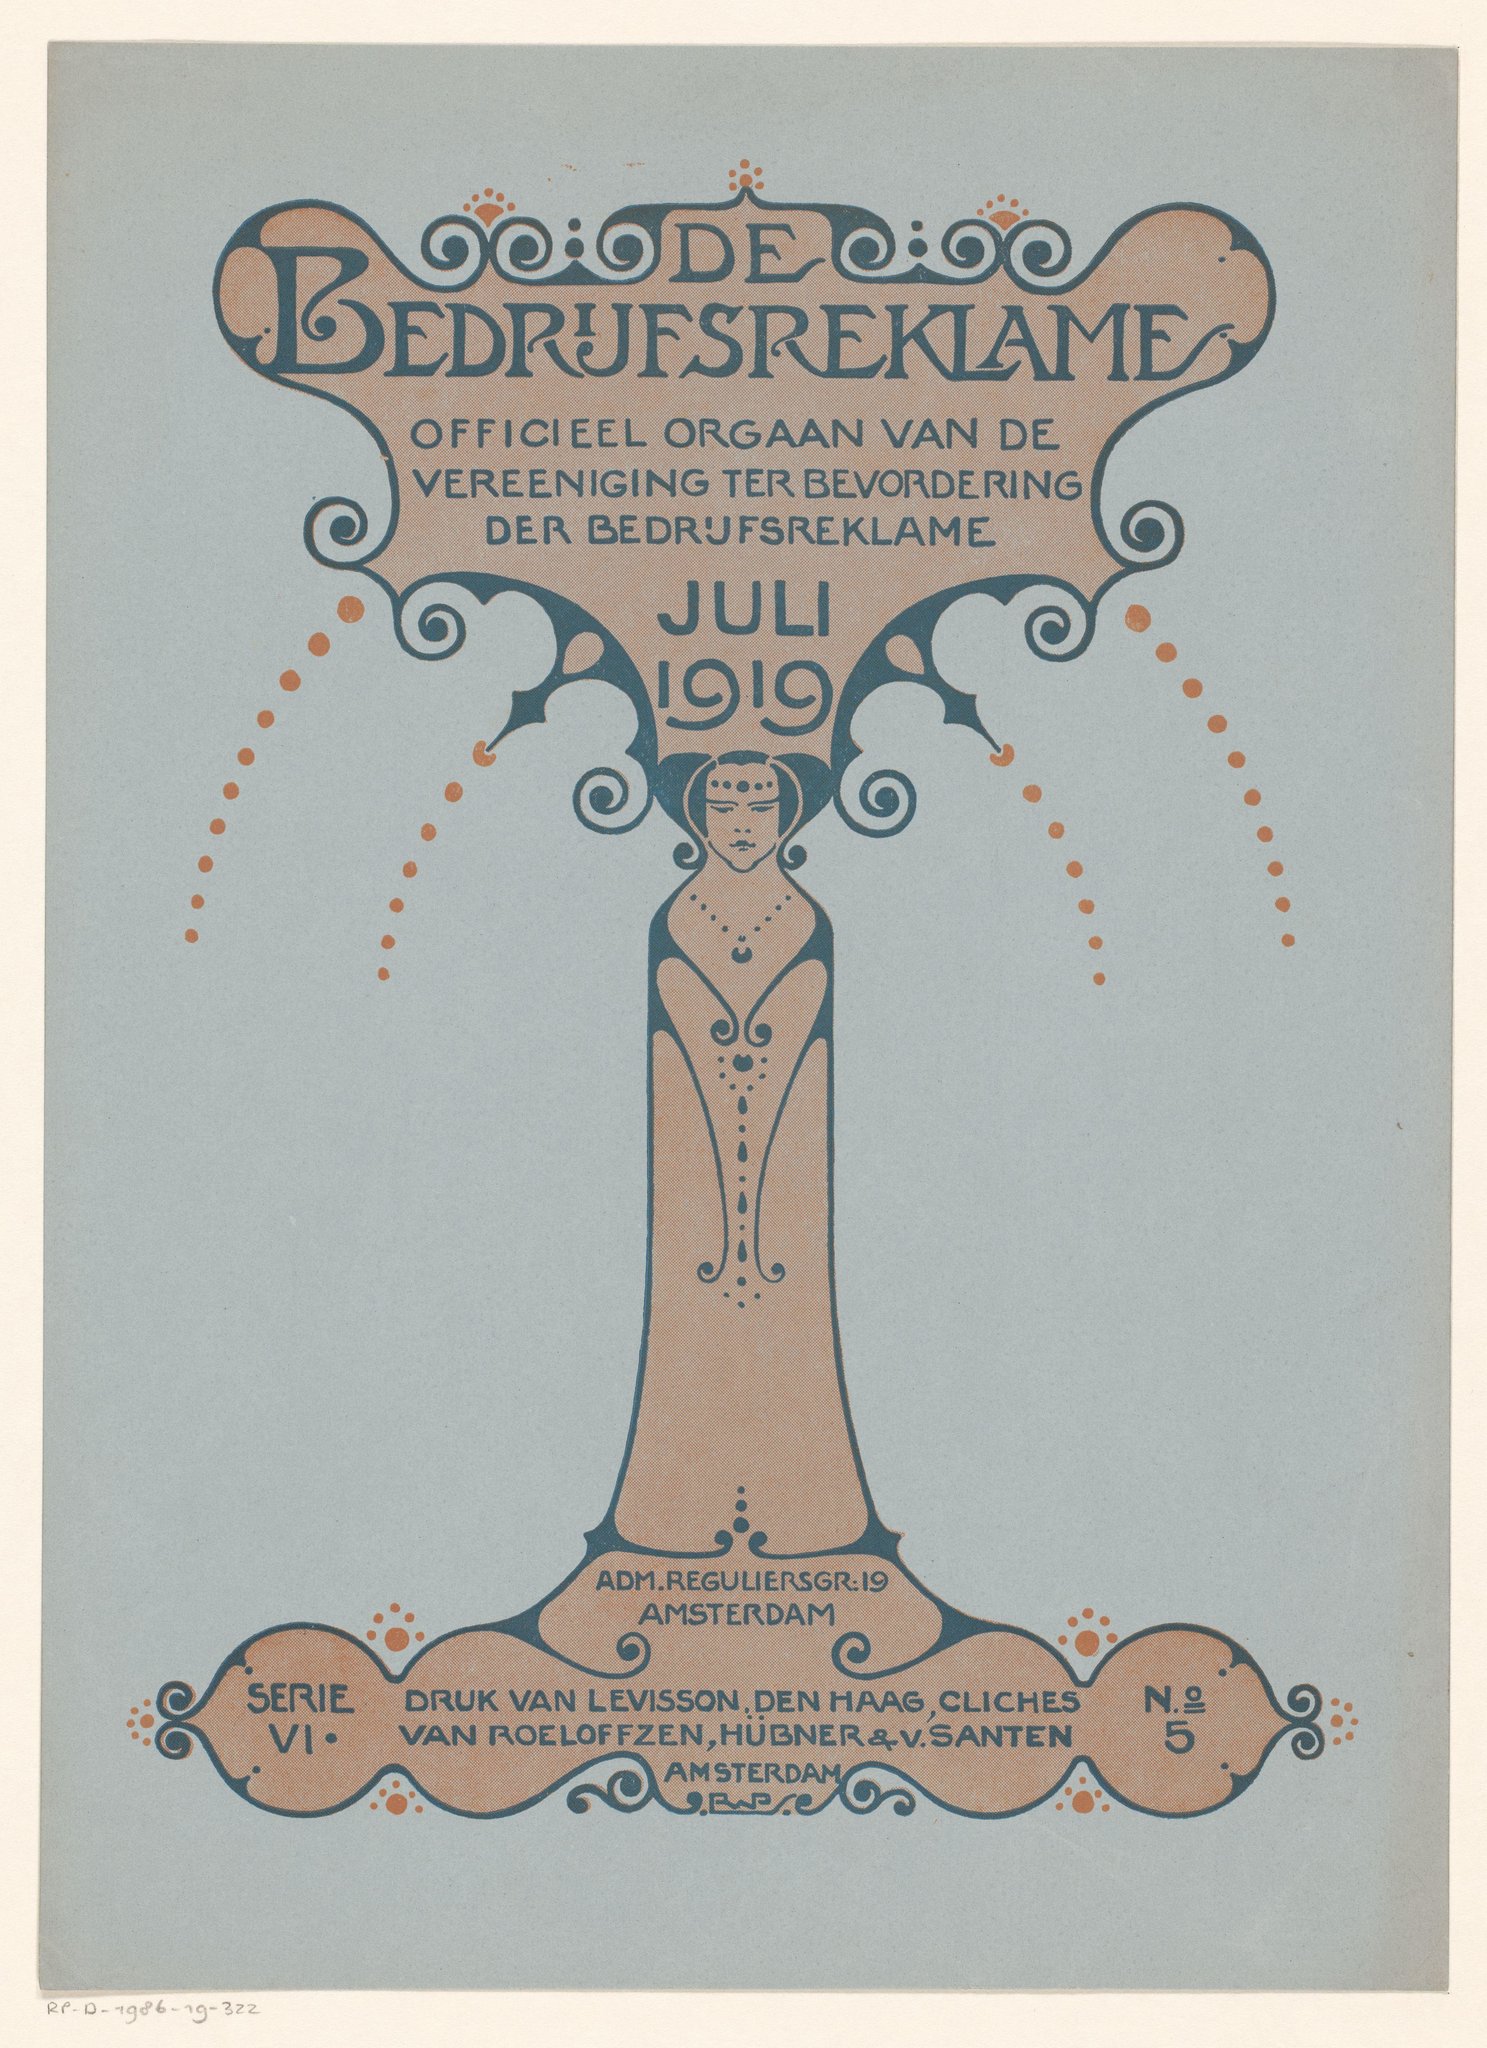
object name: photomechanical print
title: Omslag van: De Bedrijfsreklame: Officieel orgaan van de Vereeniging ter bevordering der bedrijfsreklame, juli 1919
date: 1919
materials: paper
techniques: line block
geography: the hague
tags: standing figure - aa - female human figure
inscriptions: collector's mark: ‘R:MVS.’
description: Vrouwvorm verbonden aan twee tekstkaders met ornamenten.